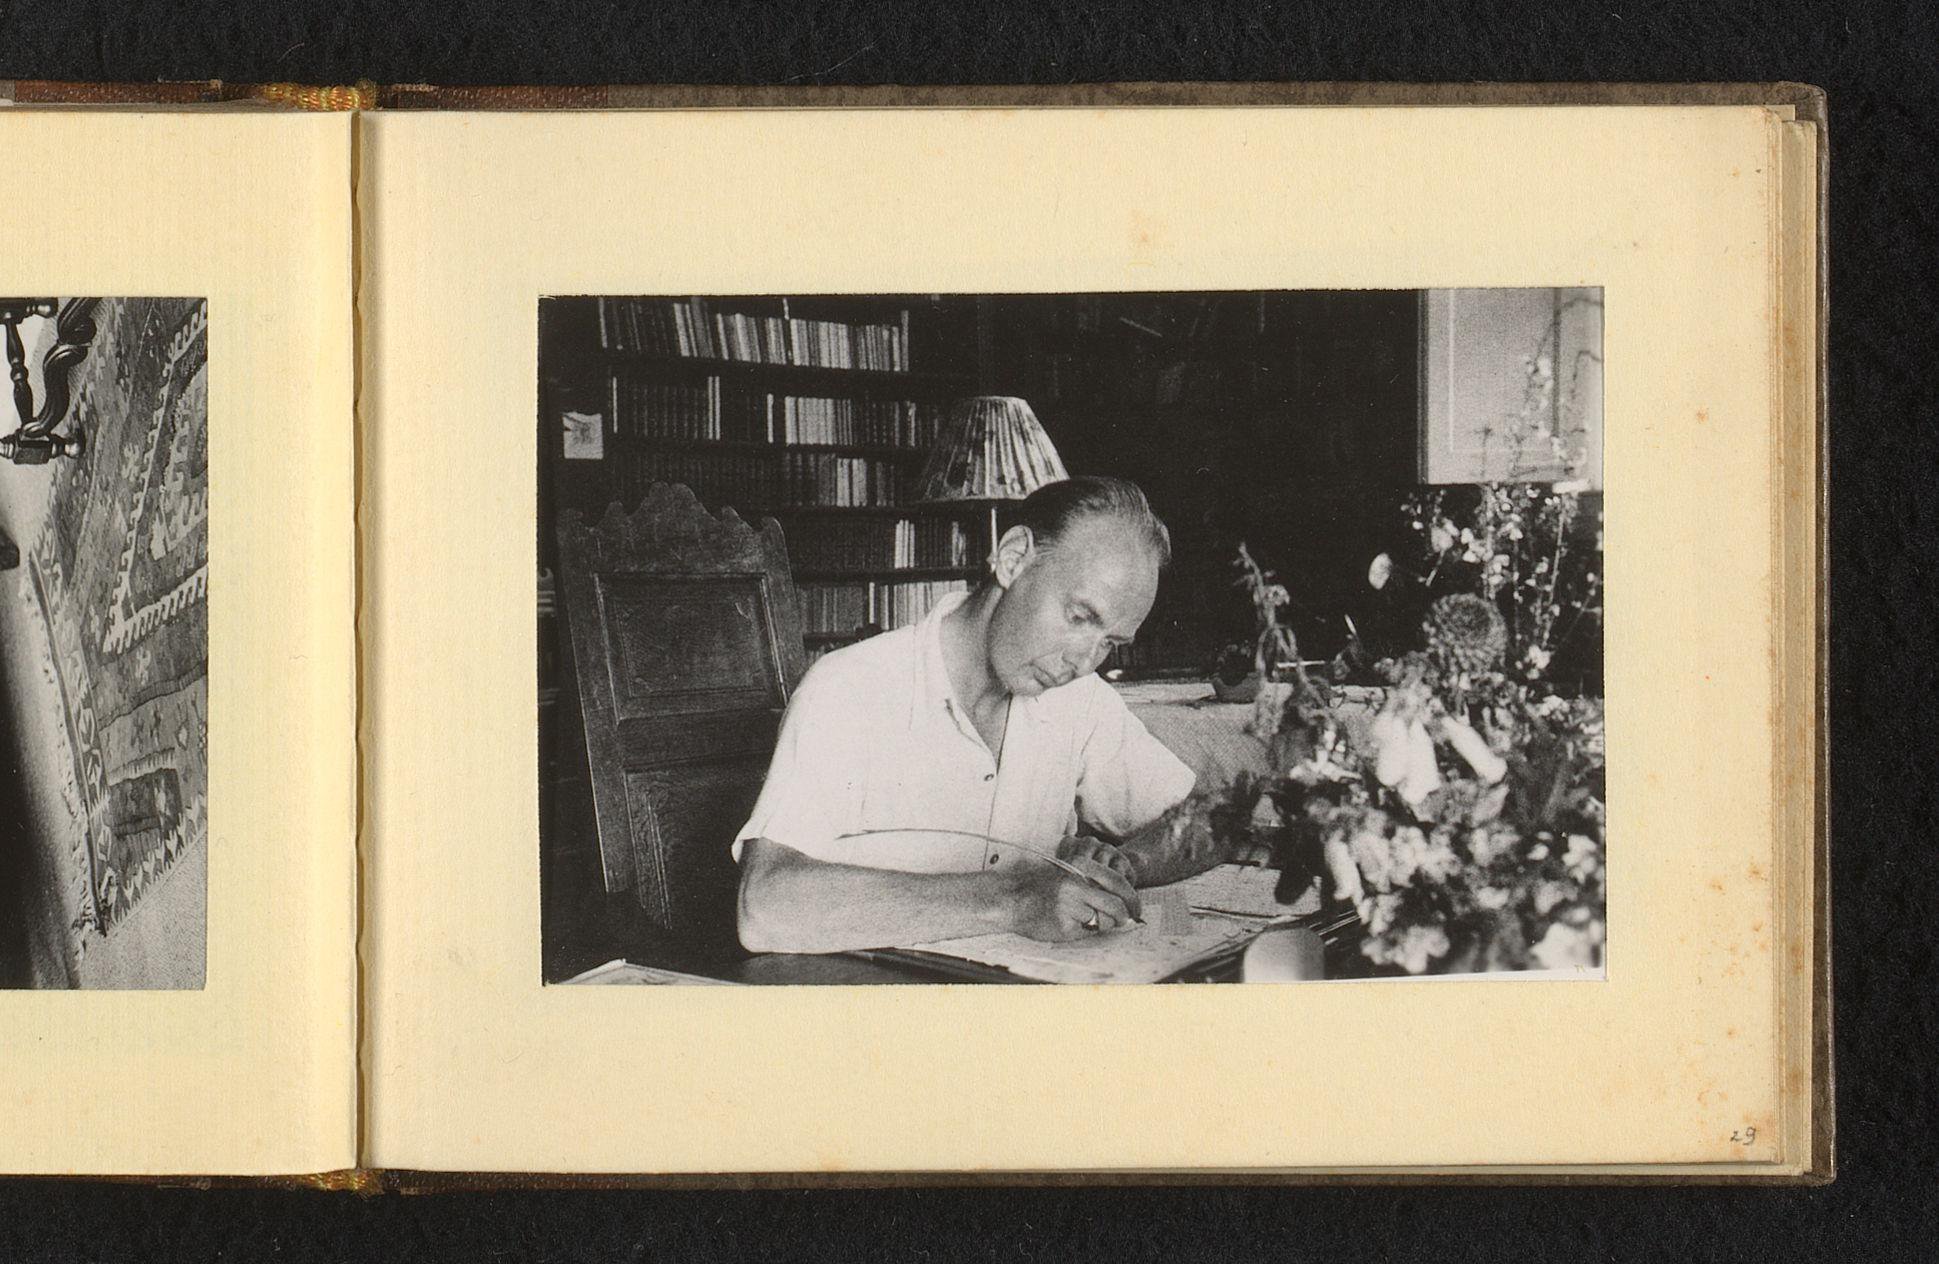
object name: album leaf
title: Schrijvende man aan een bureau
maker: norbert van den berg (1901-1972)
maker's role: amateurfotograaf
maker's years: 1901-1972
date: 1935-1950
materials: paper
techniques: gelatin silver print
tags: writing-table, writing-desk, handwriting, writing as activity, adult man